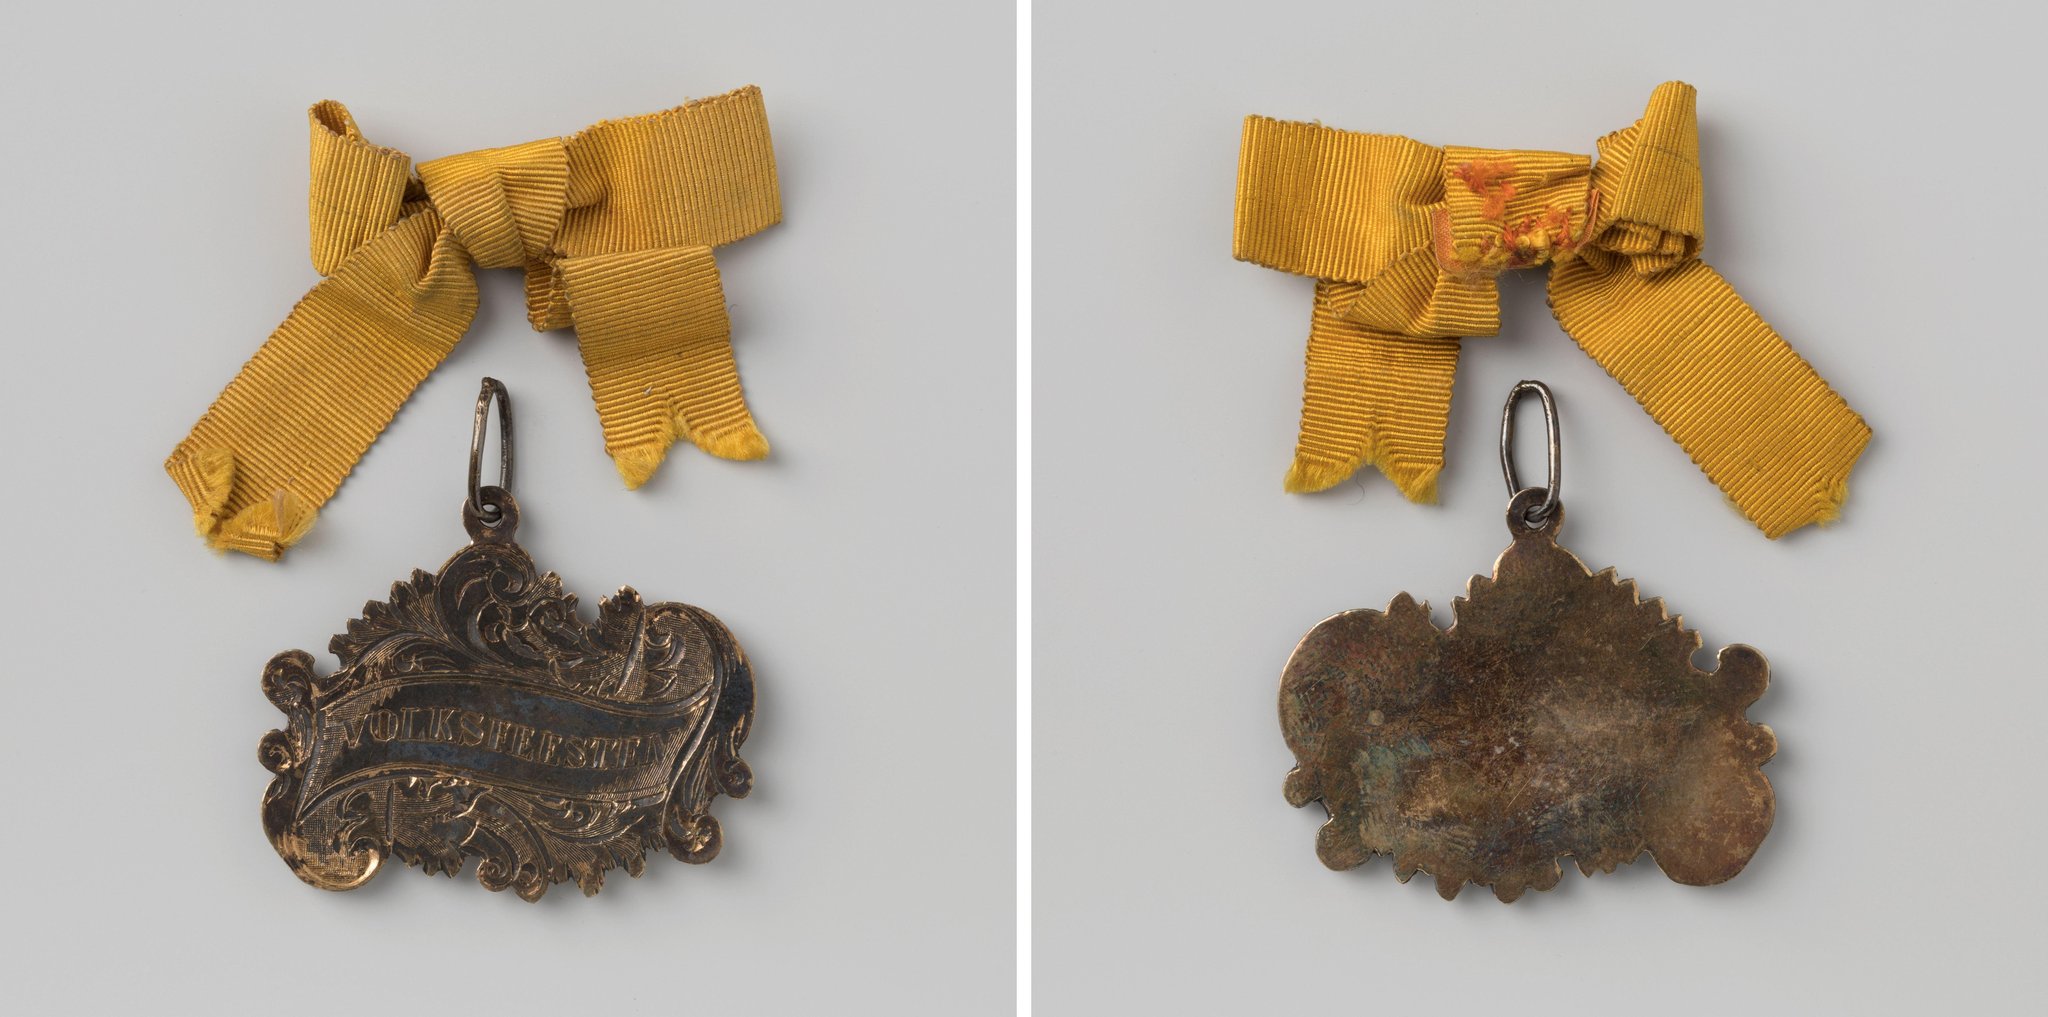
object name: insignia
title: Draagteken Volksfeesten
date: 1850-1900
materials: silver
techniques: engraving, sawing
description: Uitgezaagd en gegraveerd zilveren draagteken met ring en oog aan geel-oranje strik, met opschrift "Volksfeesten".